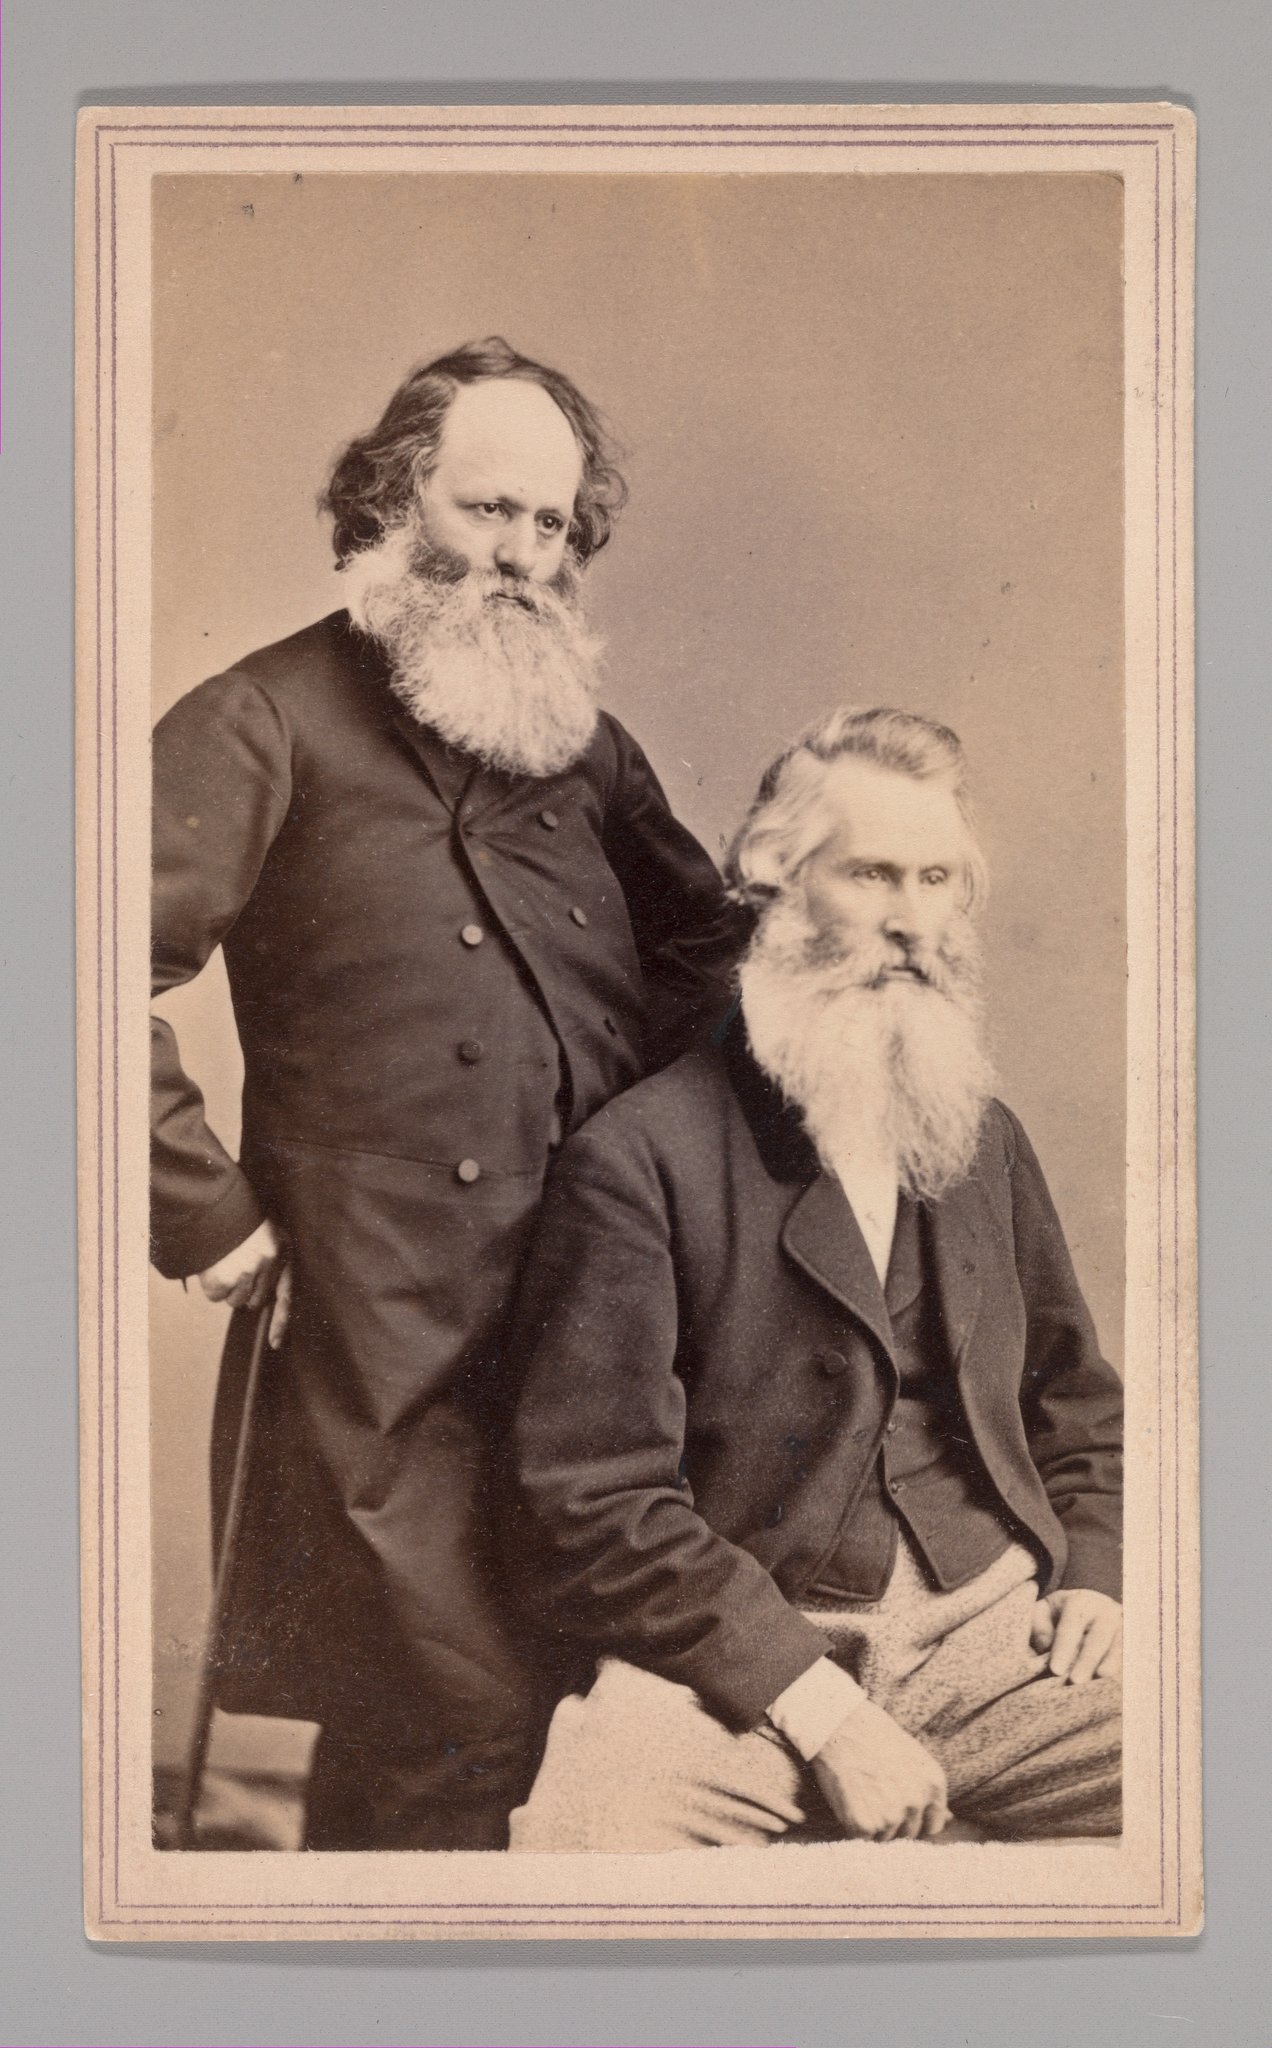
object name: carte de visite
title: [Elliott and Palmer ?]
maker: thompson gallery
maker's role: photography studio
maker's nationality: american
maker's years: 1860-1869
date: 1864-1866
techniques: albumen silver print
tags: men,portraits